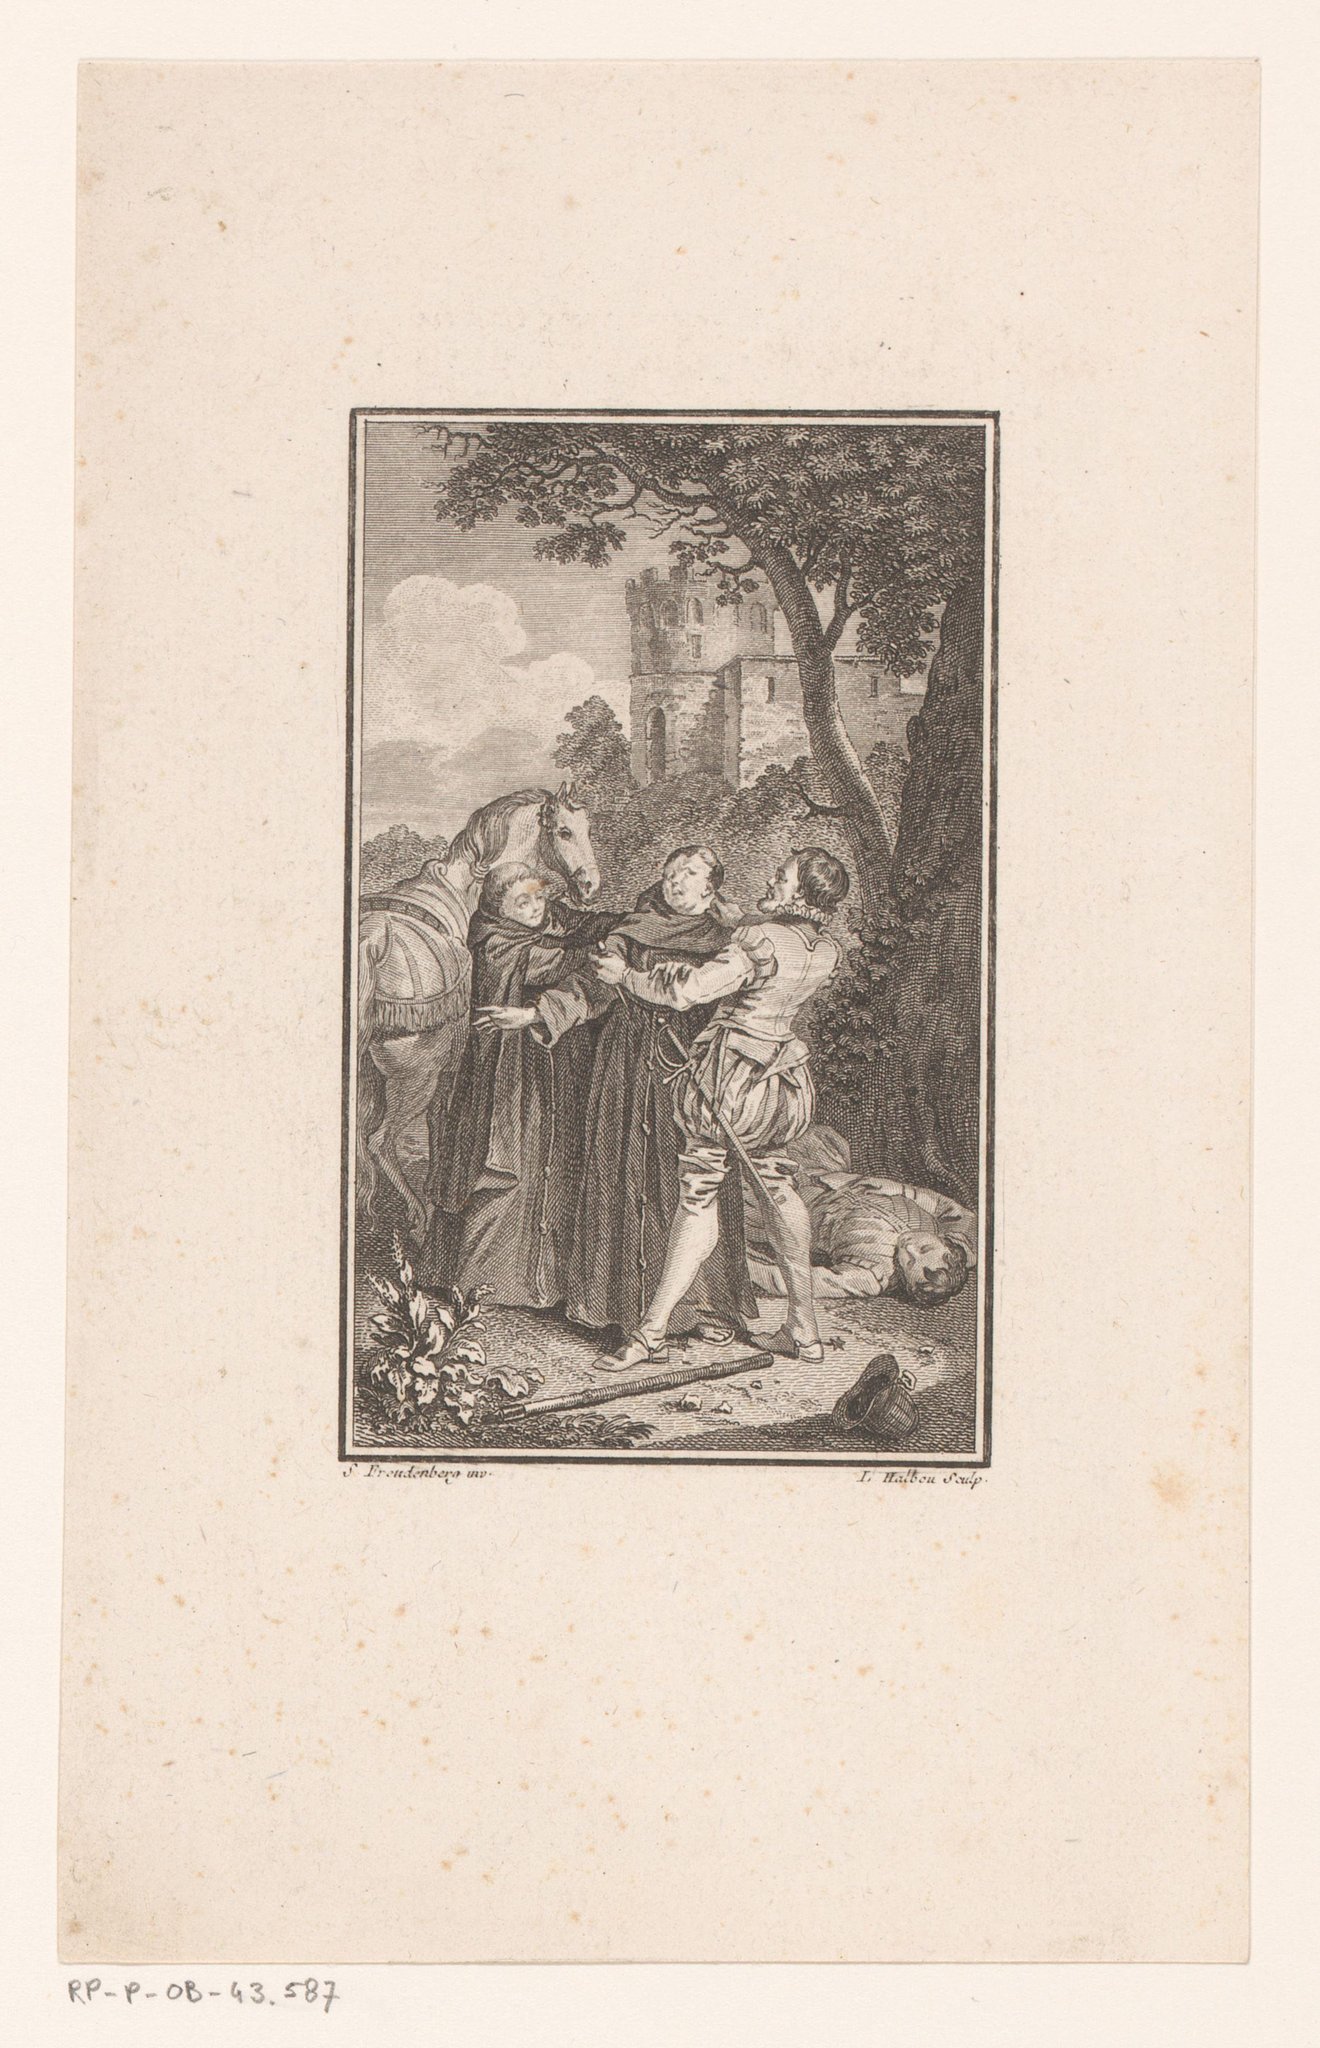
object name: print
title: Edelman met twee monniken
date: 1781-1782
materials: paper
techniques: etching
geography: bern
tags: monk(s), friar(s), nobility and patriciate; chivalry, knighthood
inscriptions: collector's mark: Lugt 2228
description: Prent uit: Les Nouvelles de Marguerite, reine de Navarre. Bern: la nouvelle Société Typographique, 1780-1781.